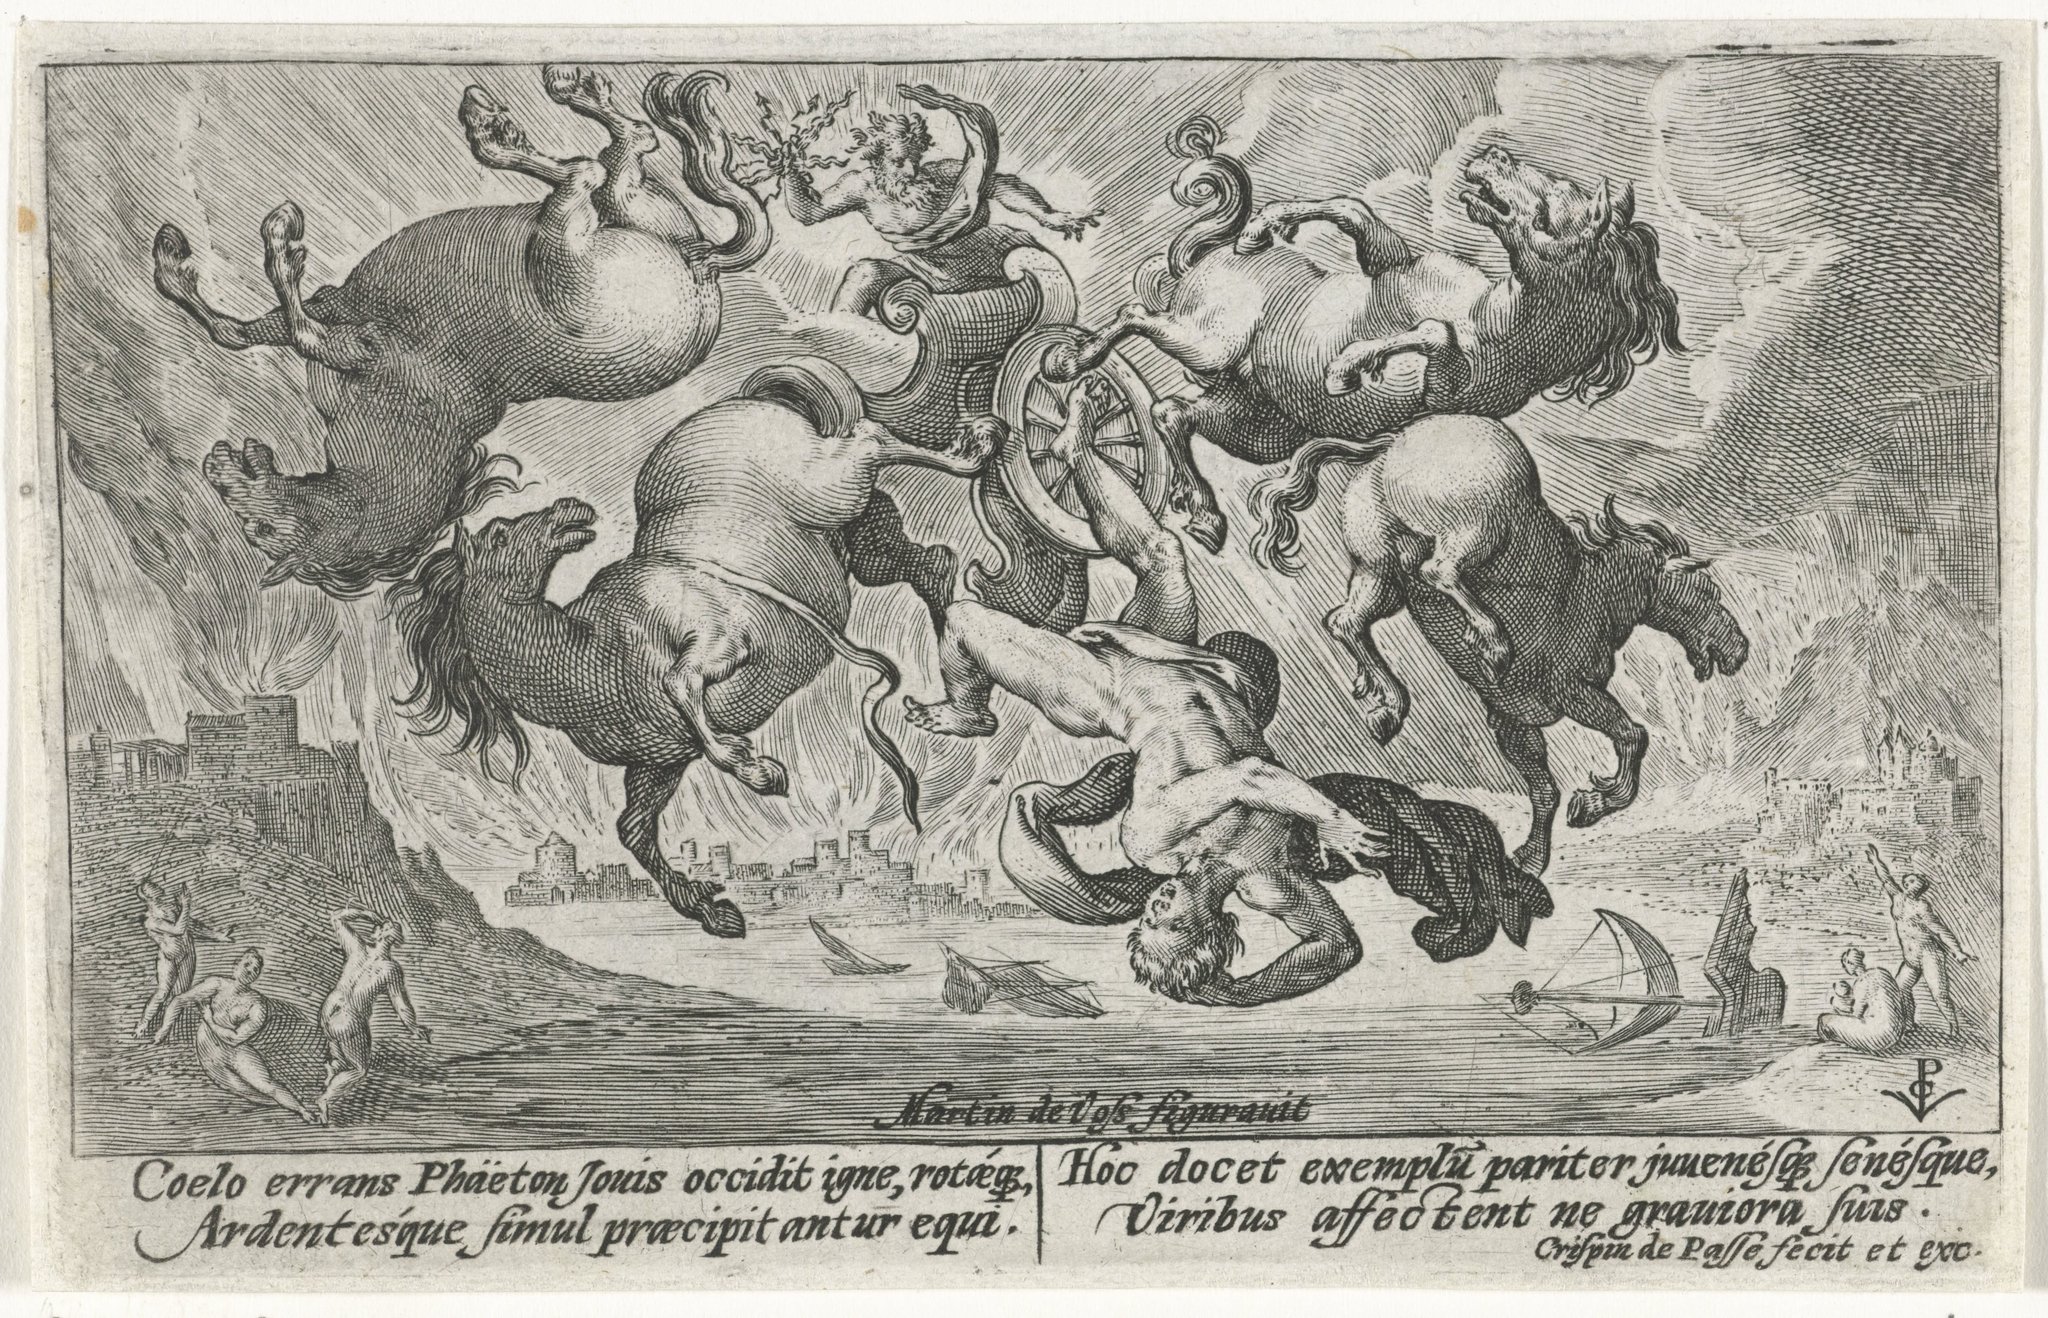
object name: print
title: Metamorfosen van Ovidius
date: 1602-1607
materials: paper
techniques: engraving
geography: cologne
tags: fall of phaethon; he is struck by a thunderbolt of jupiter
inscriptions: collector's mark: Lugt 2228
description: De paarden van de wagen van Phaëthon zijn op hol geslagen en hebben de aarde in brand gezet, waarna Jupiter met zijn bliksemschicht de wagen vernielt. Phaëthon, zijn wagen en de vier paarden storten neer. In de marge een vierregelig onderschrift, in twee kolommen, in het Latijn.